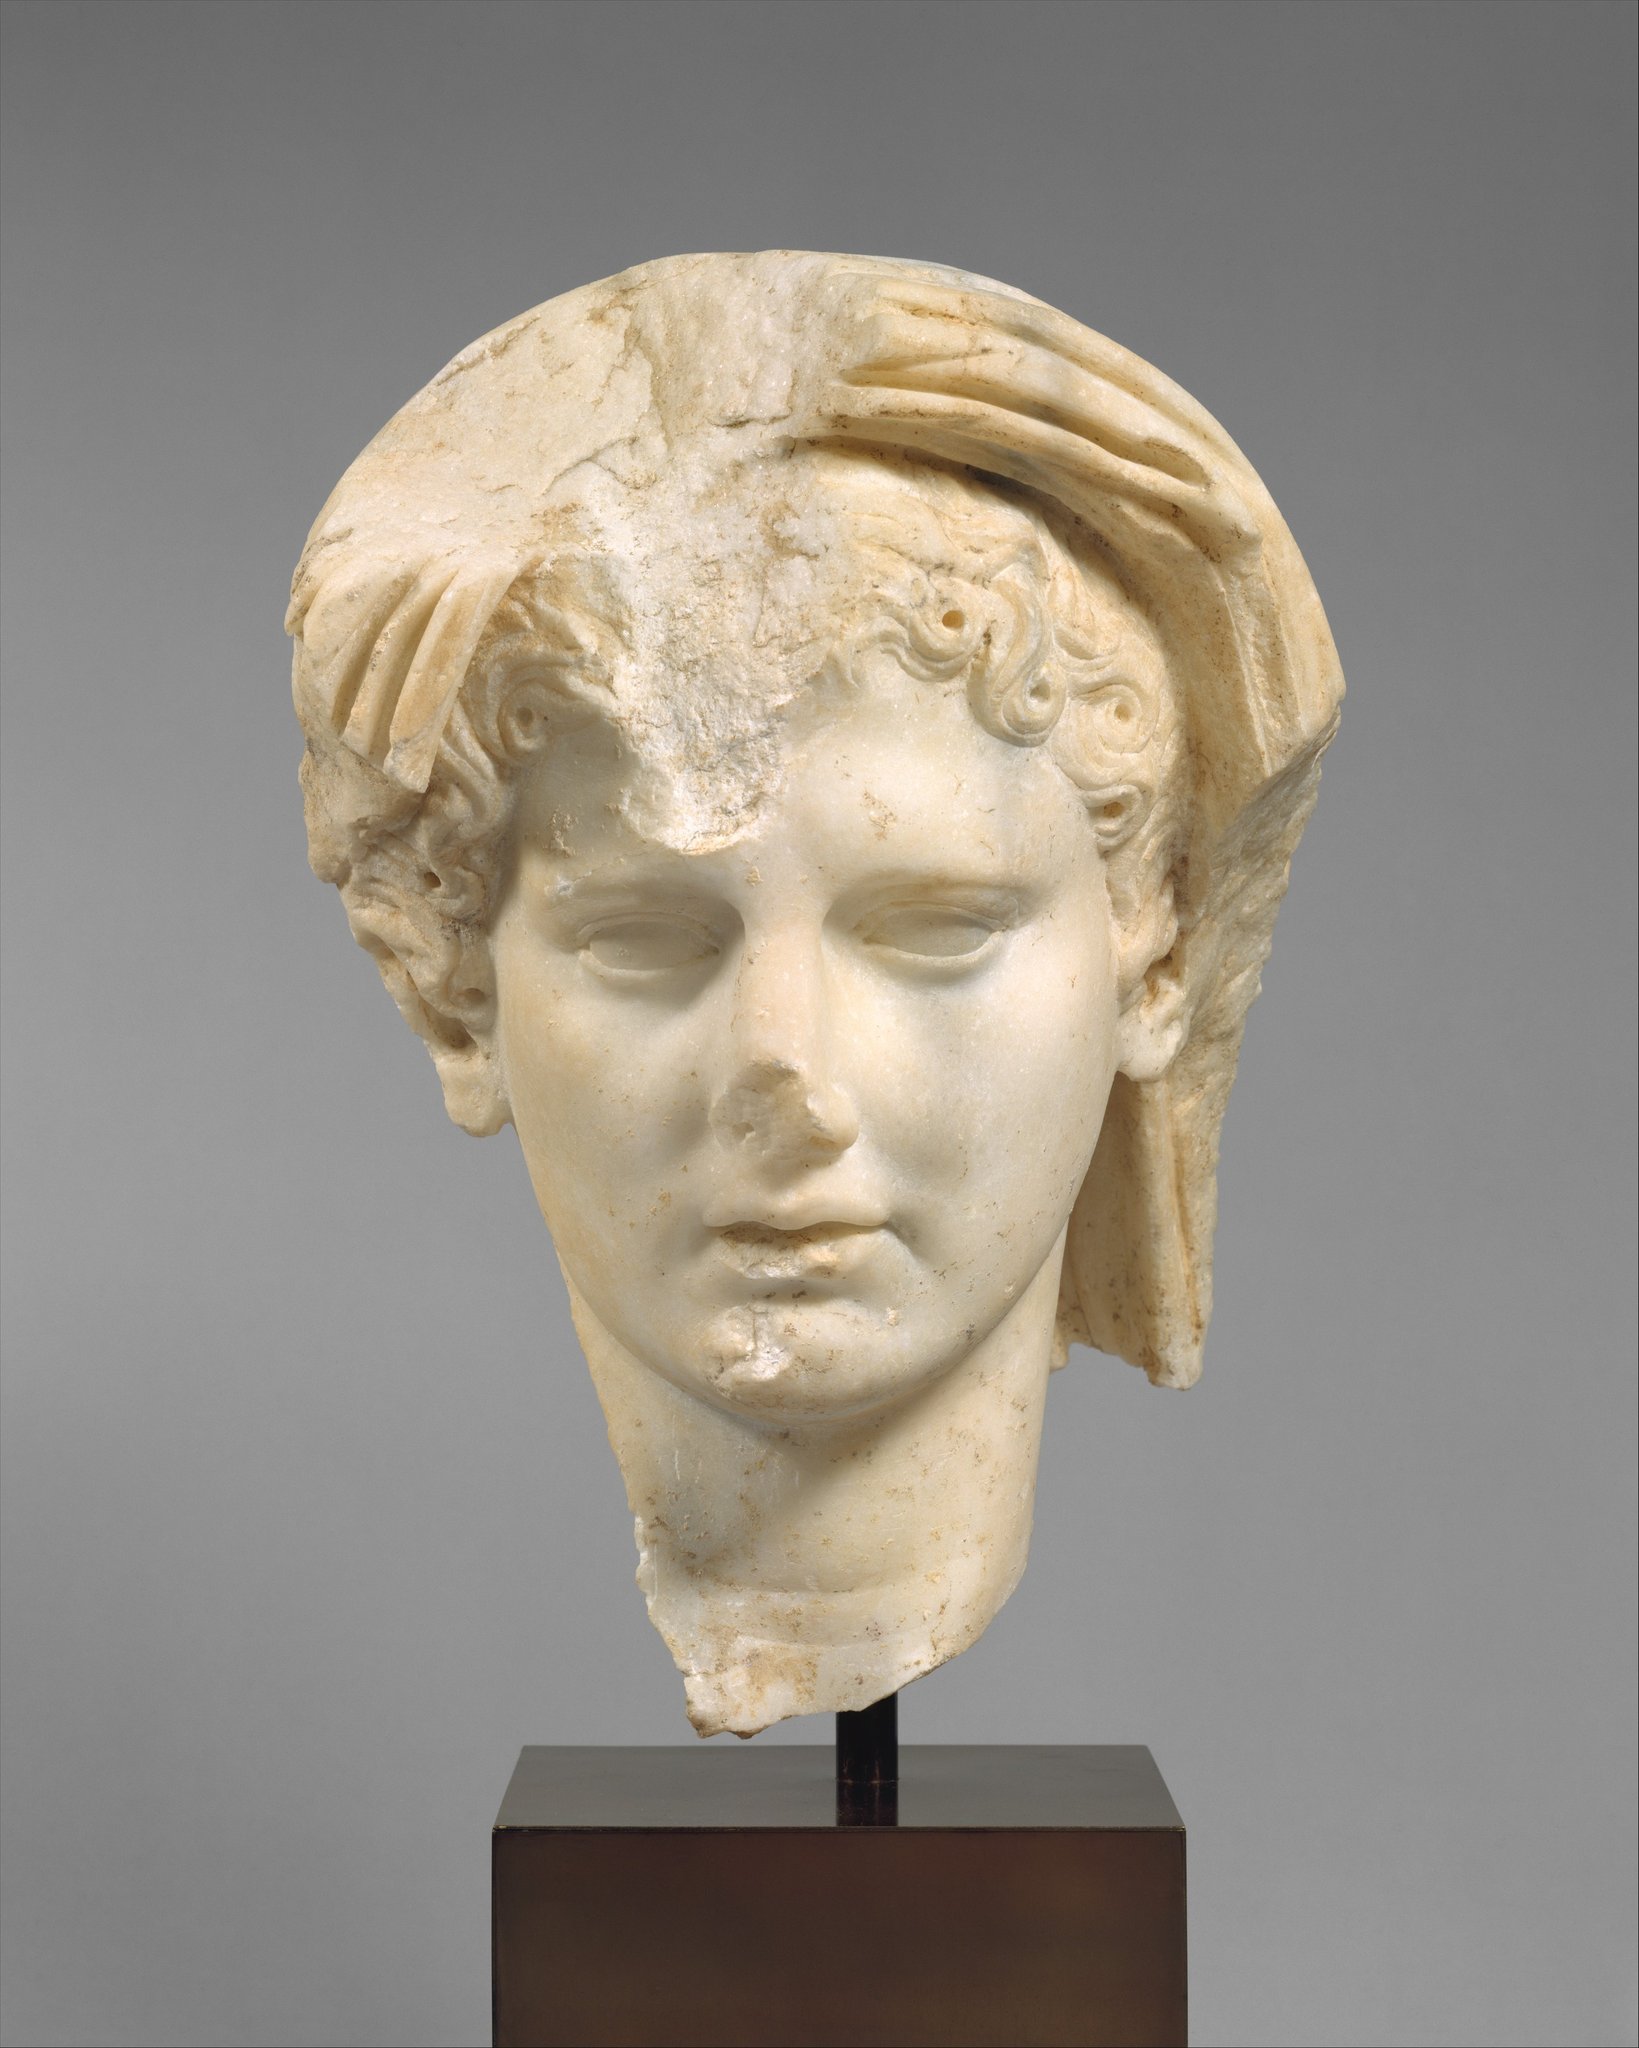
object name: head of a man, veiled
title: Marble head of a veiled man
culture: roman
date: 1-50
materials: marble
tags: heads,men